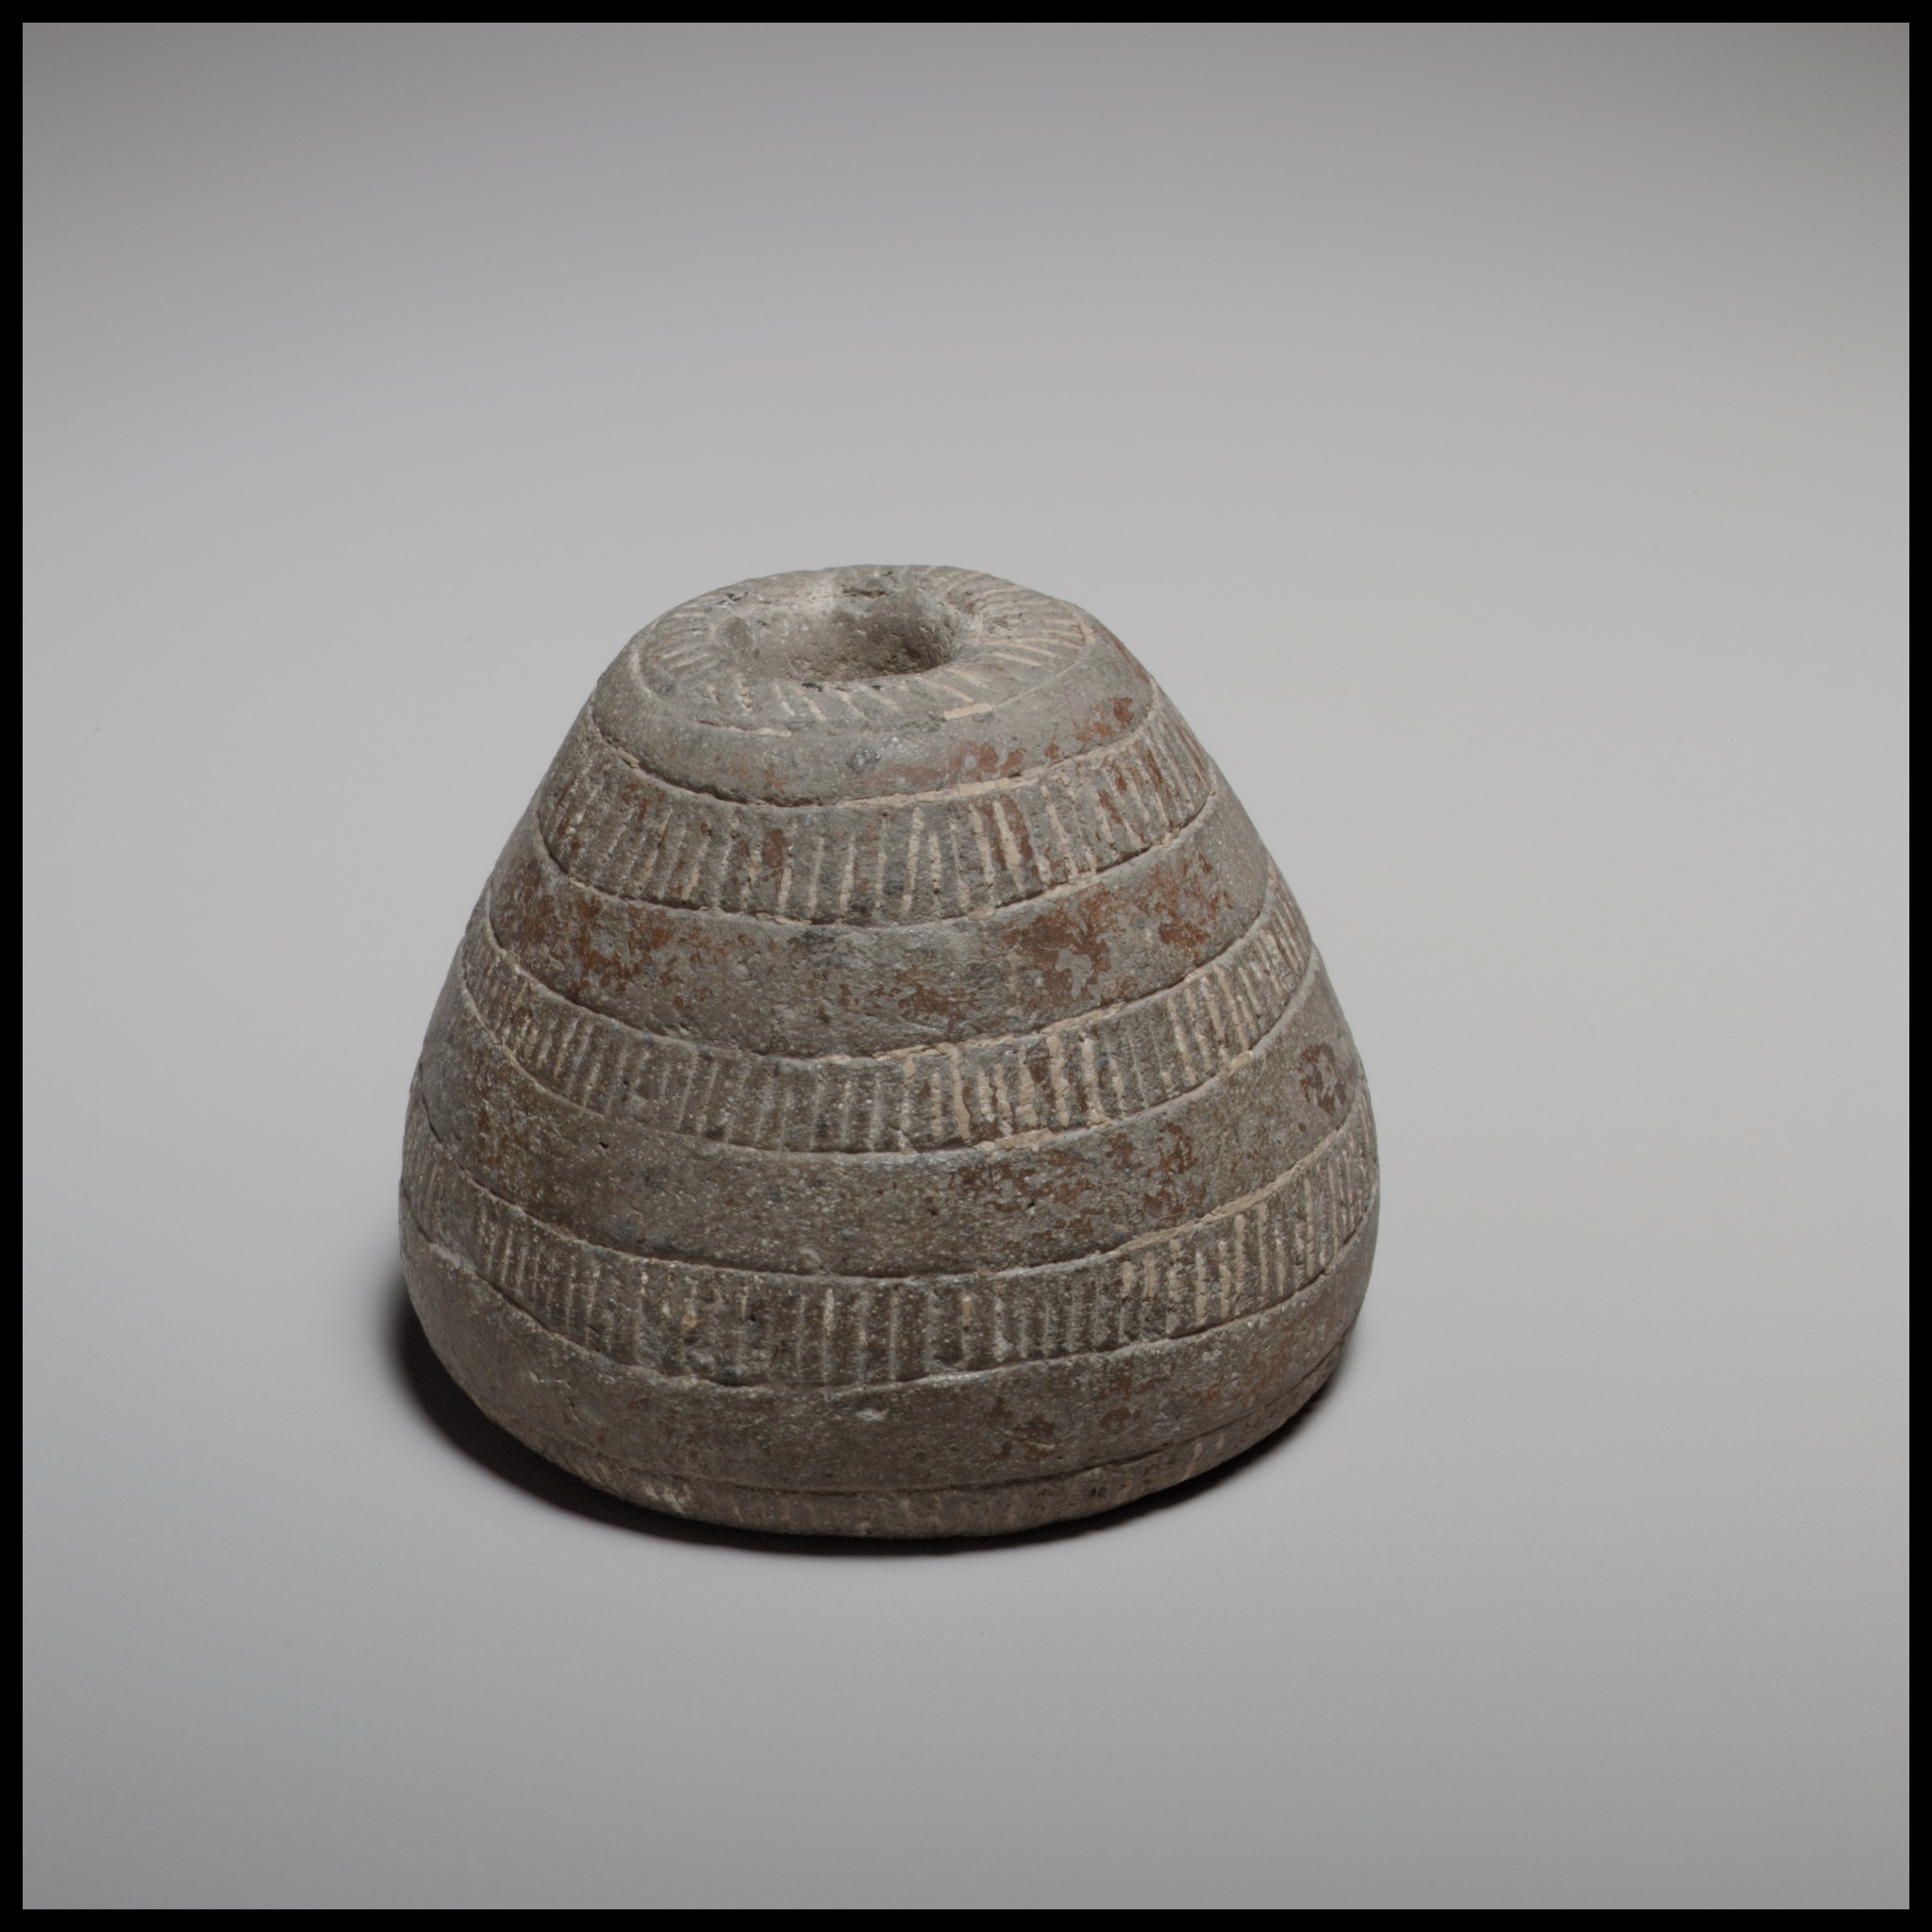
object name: spindle whorl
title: Conical spindle-whorl with flat base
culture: cypriot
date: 1900-1725 BCE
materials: terracotta